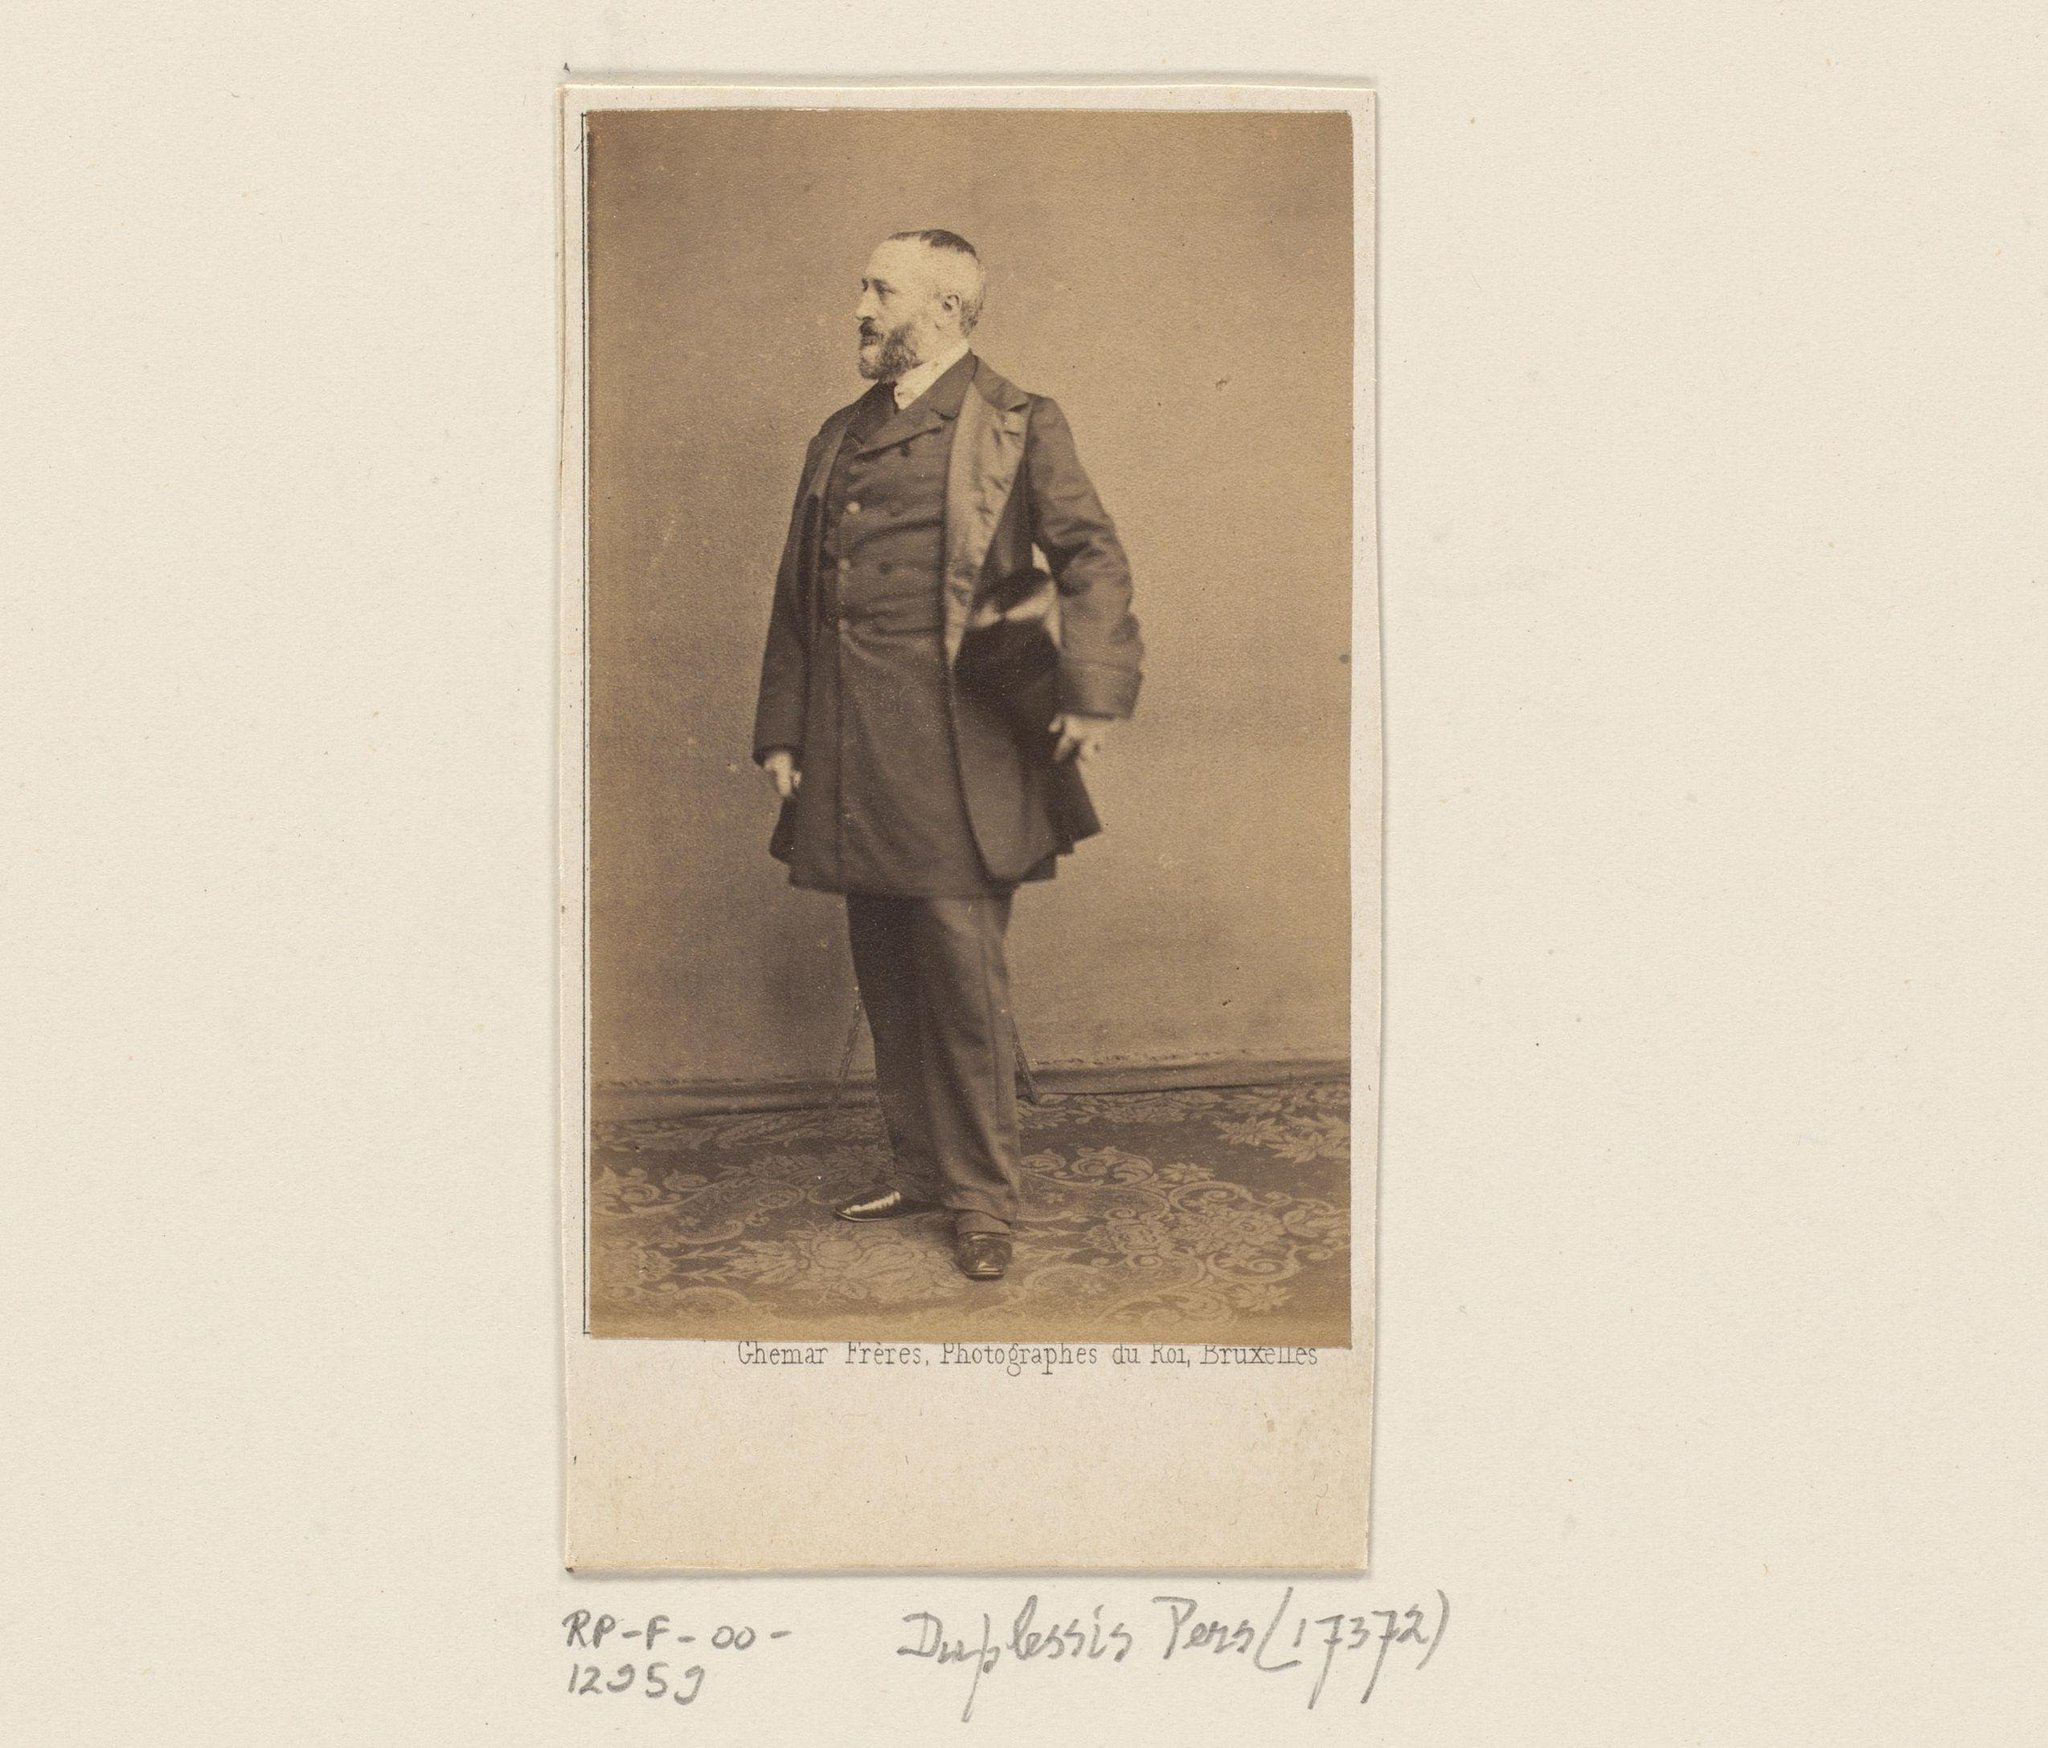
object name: photograph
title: Portret van Louis Gallait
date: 1865-1887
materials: cardboard, paper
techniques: albumen print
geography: brussels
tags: painter, print maker, draughtsman, louis gallait, historical persons, portrait, self-portrait of painter, head-gear: top hat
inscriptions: inscription: ‘Atelier de Photographie/ Ghémar Frères (...) Bruxelles’, number: ‘16’